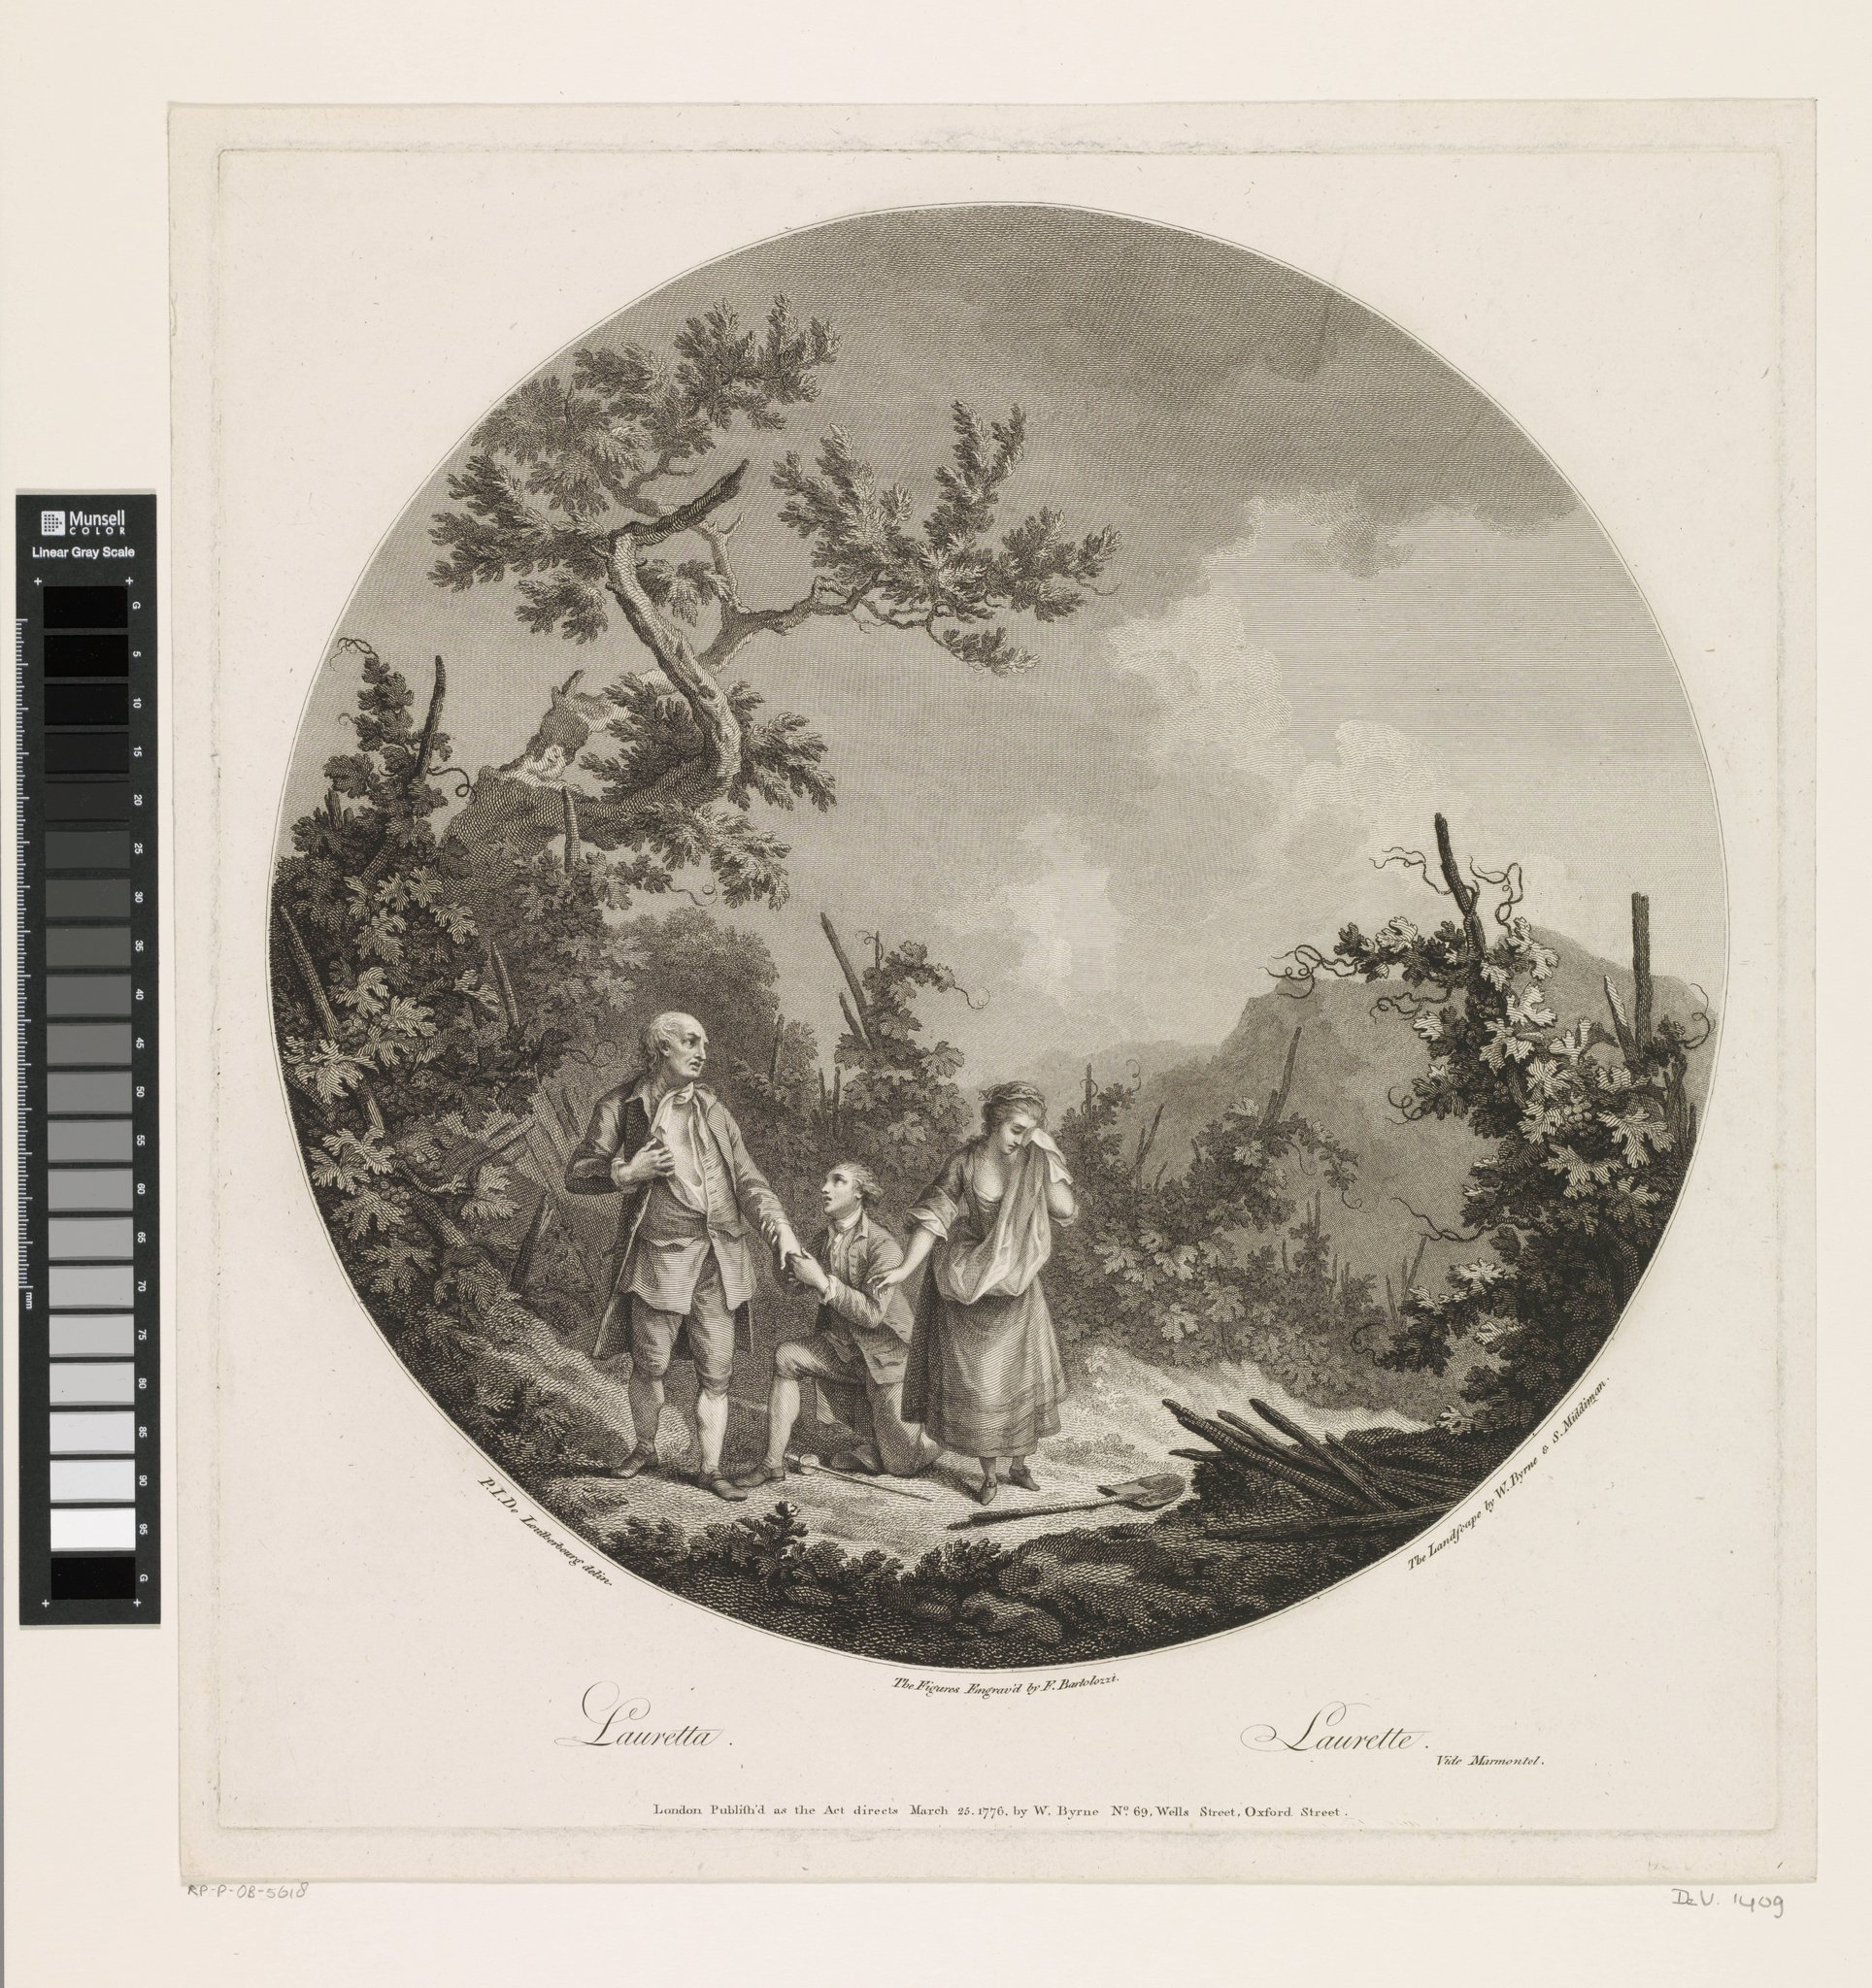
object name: print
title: Lauretta / Laurette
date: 1776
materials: paper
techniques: engraving, etching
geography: london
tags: vineyard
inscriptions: collector's mark: Lugt 2228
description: Een staande man, een geknielde jongen die zijn hand vasthoudt en een treurende jonge vrouw in een wijngaard.